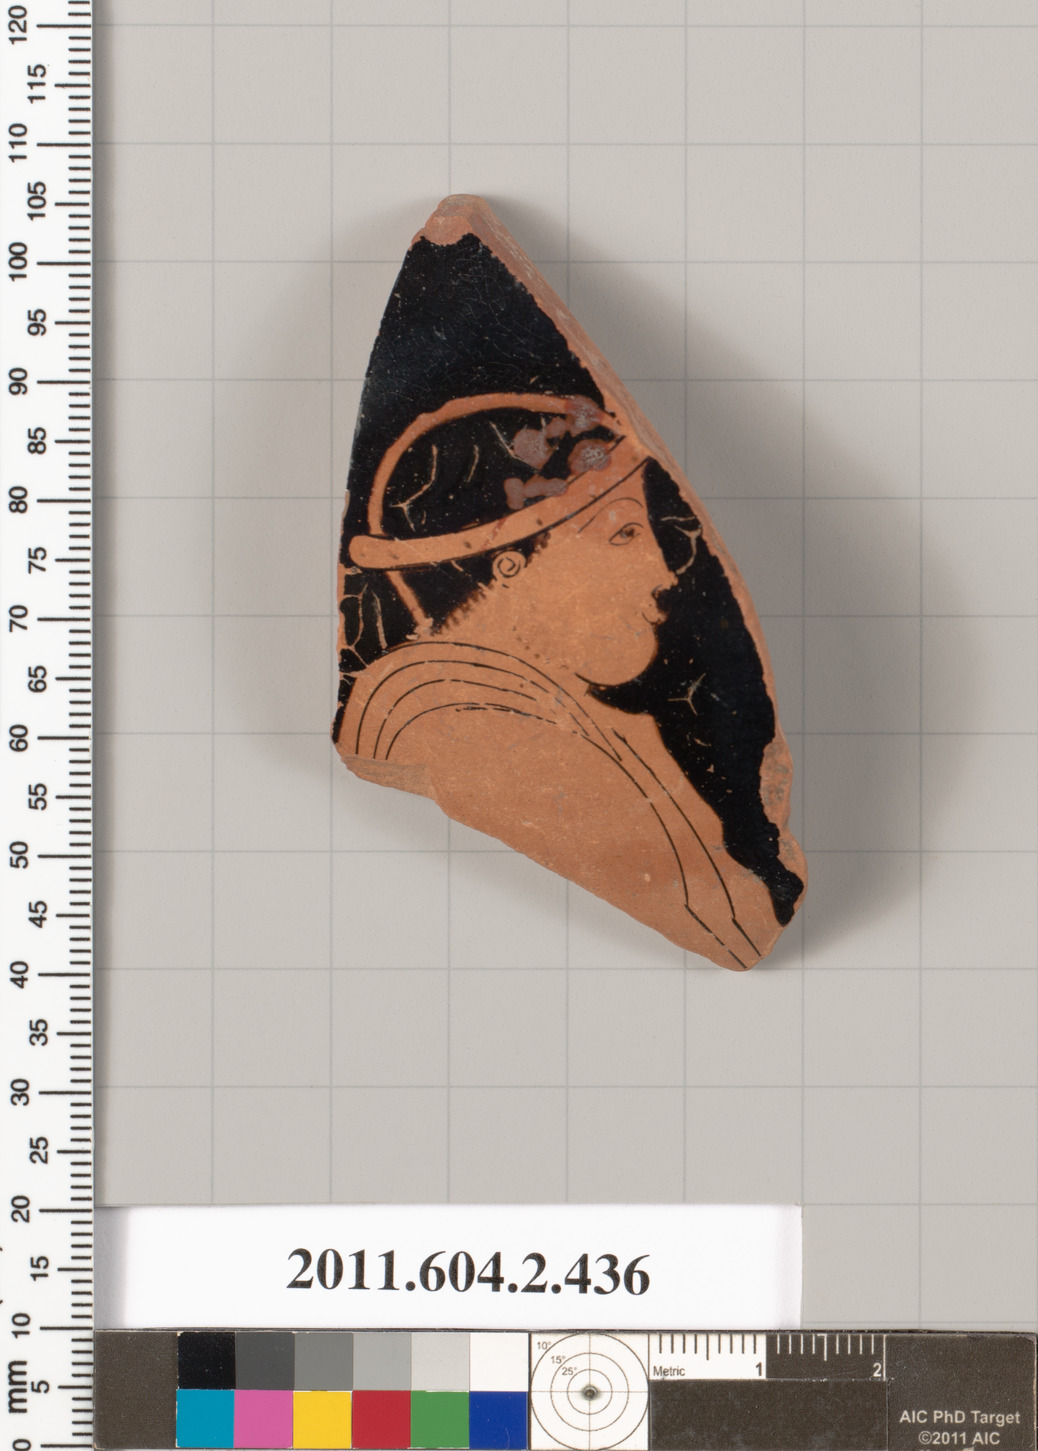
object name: column krater fragment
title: Terracotta fragment of a column-krater (bowl for mixing wine and water)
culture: greek, attic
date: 450-440 BCE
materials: terracotta